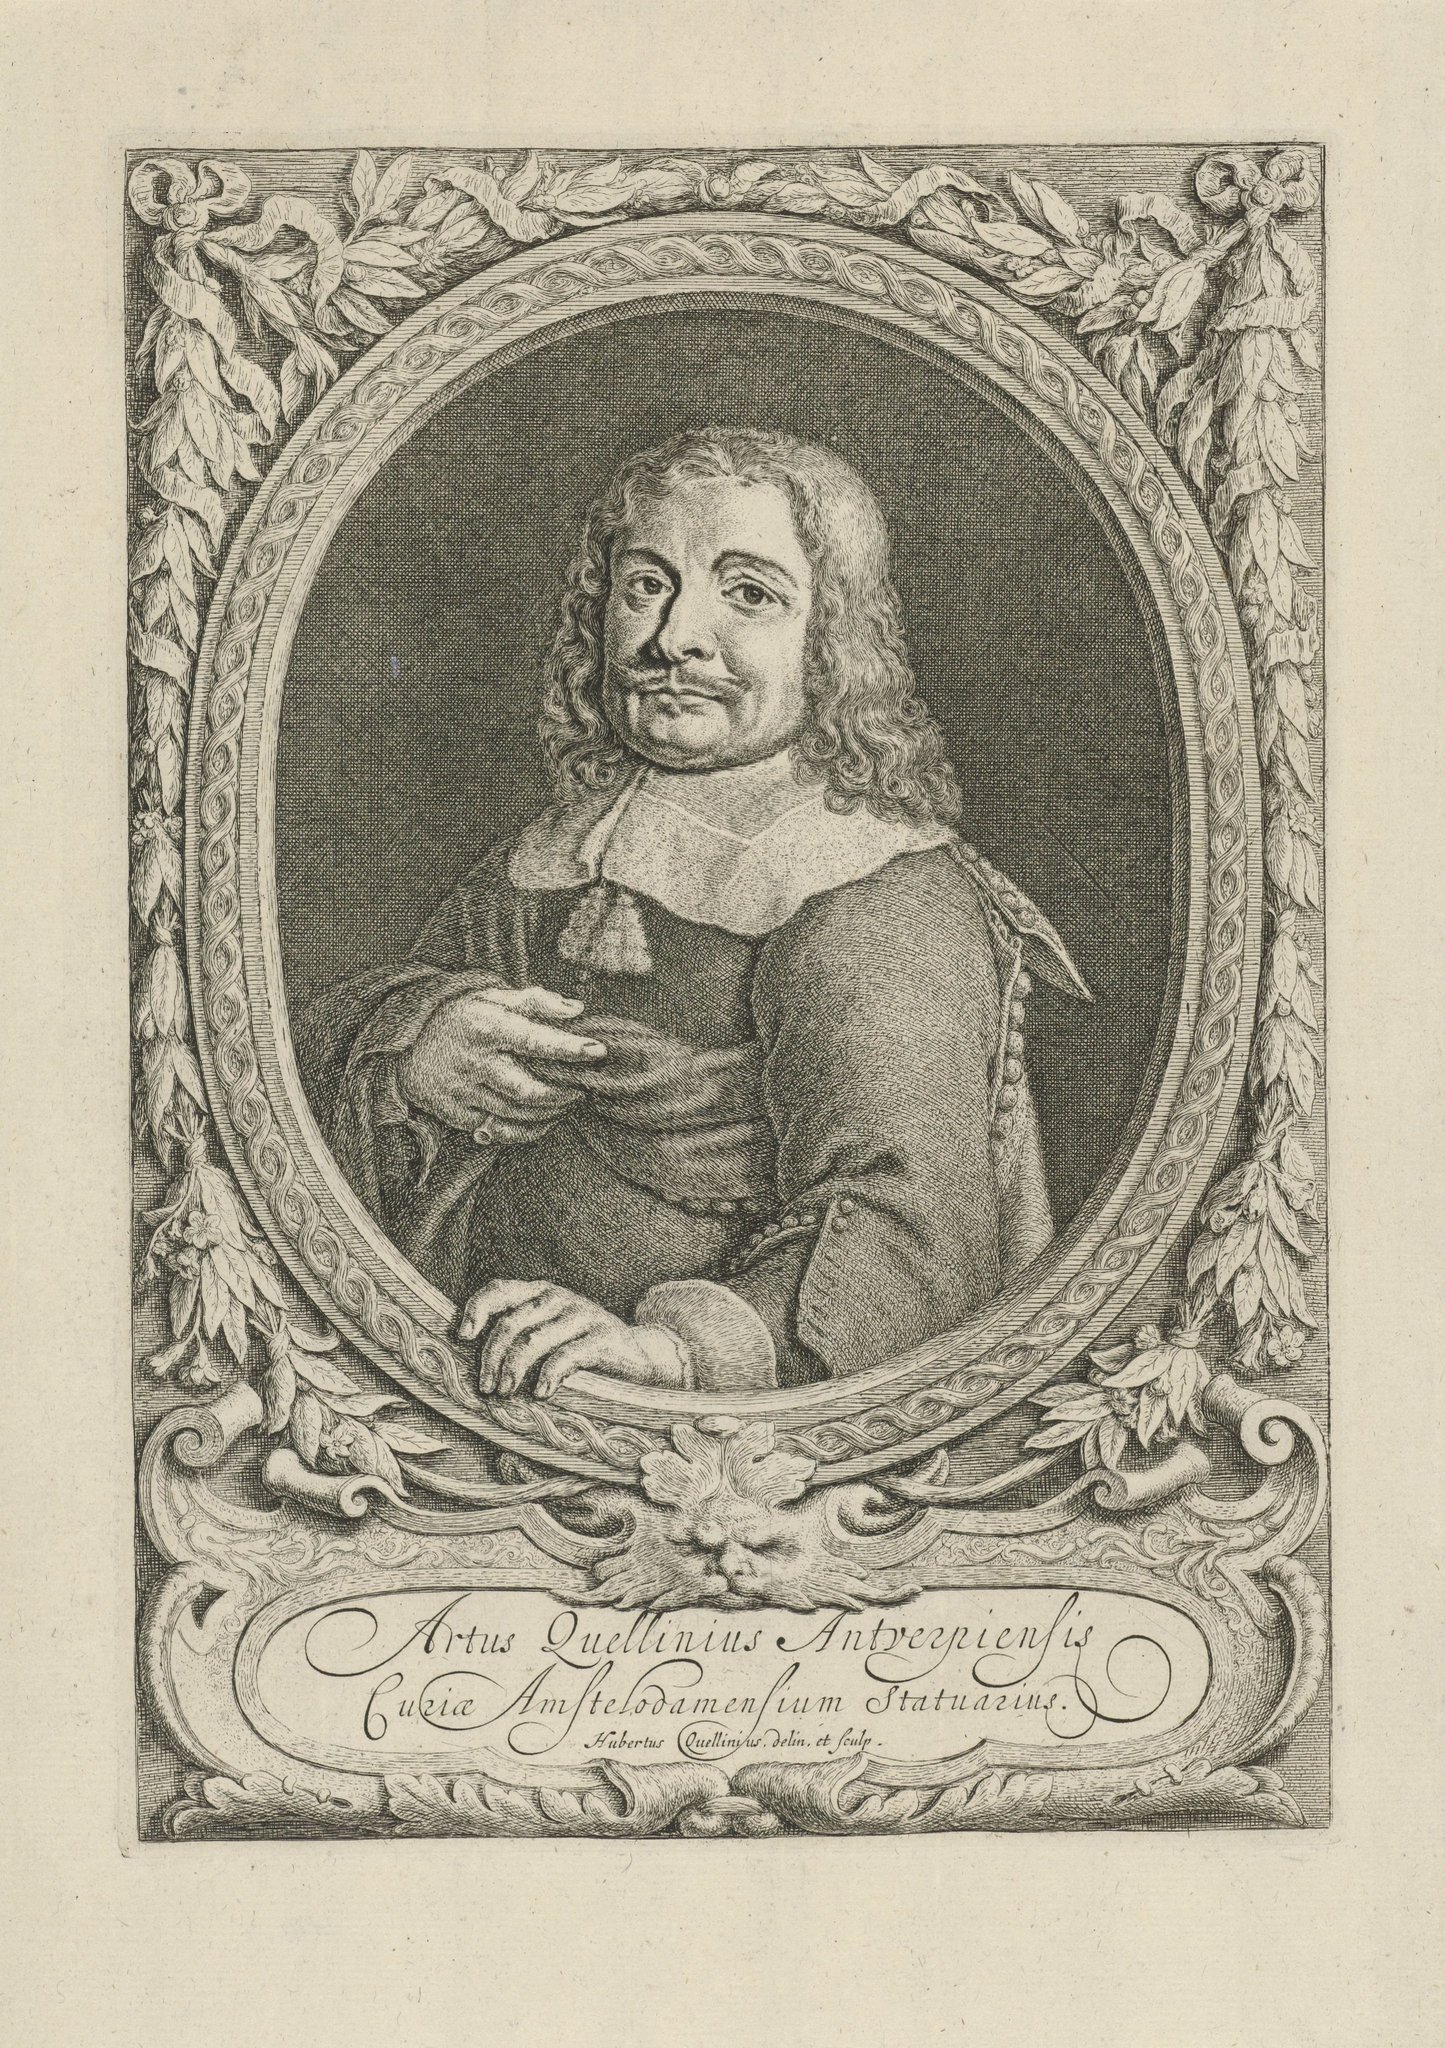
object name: print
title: Portret van Artus Quellinus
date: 1655-1668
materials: paper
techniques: engraving, etching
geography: amsterdam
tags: antwerp, print maker, draughtsman, sculptor, artus quellinus (i)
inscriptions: collector's mark: Lugt 2228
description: Illustratie uit: Hubertus Quellinus en Artus Quellinus, Prima [-secunda] pars praecipuarum effigierum ac ornamentorum, amplissimae curiae Amstelredamensis (...), Amsterdam, 1655 - 1668.